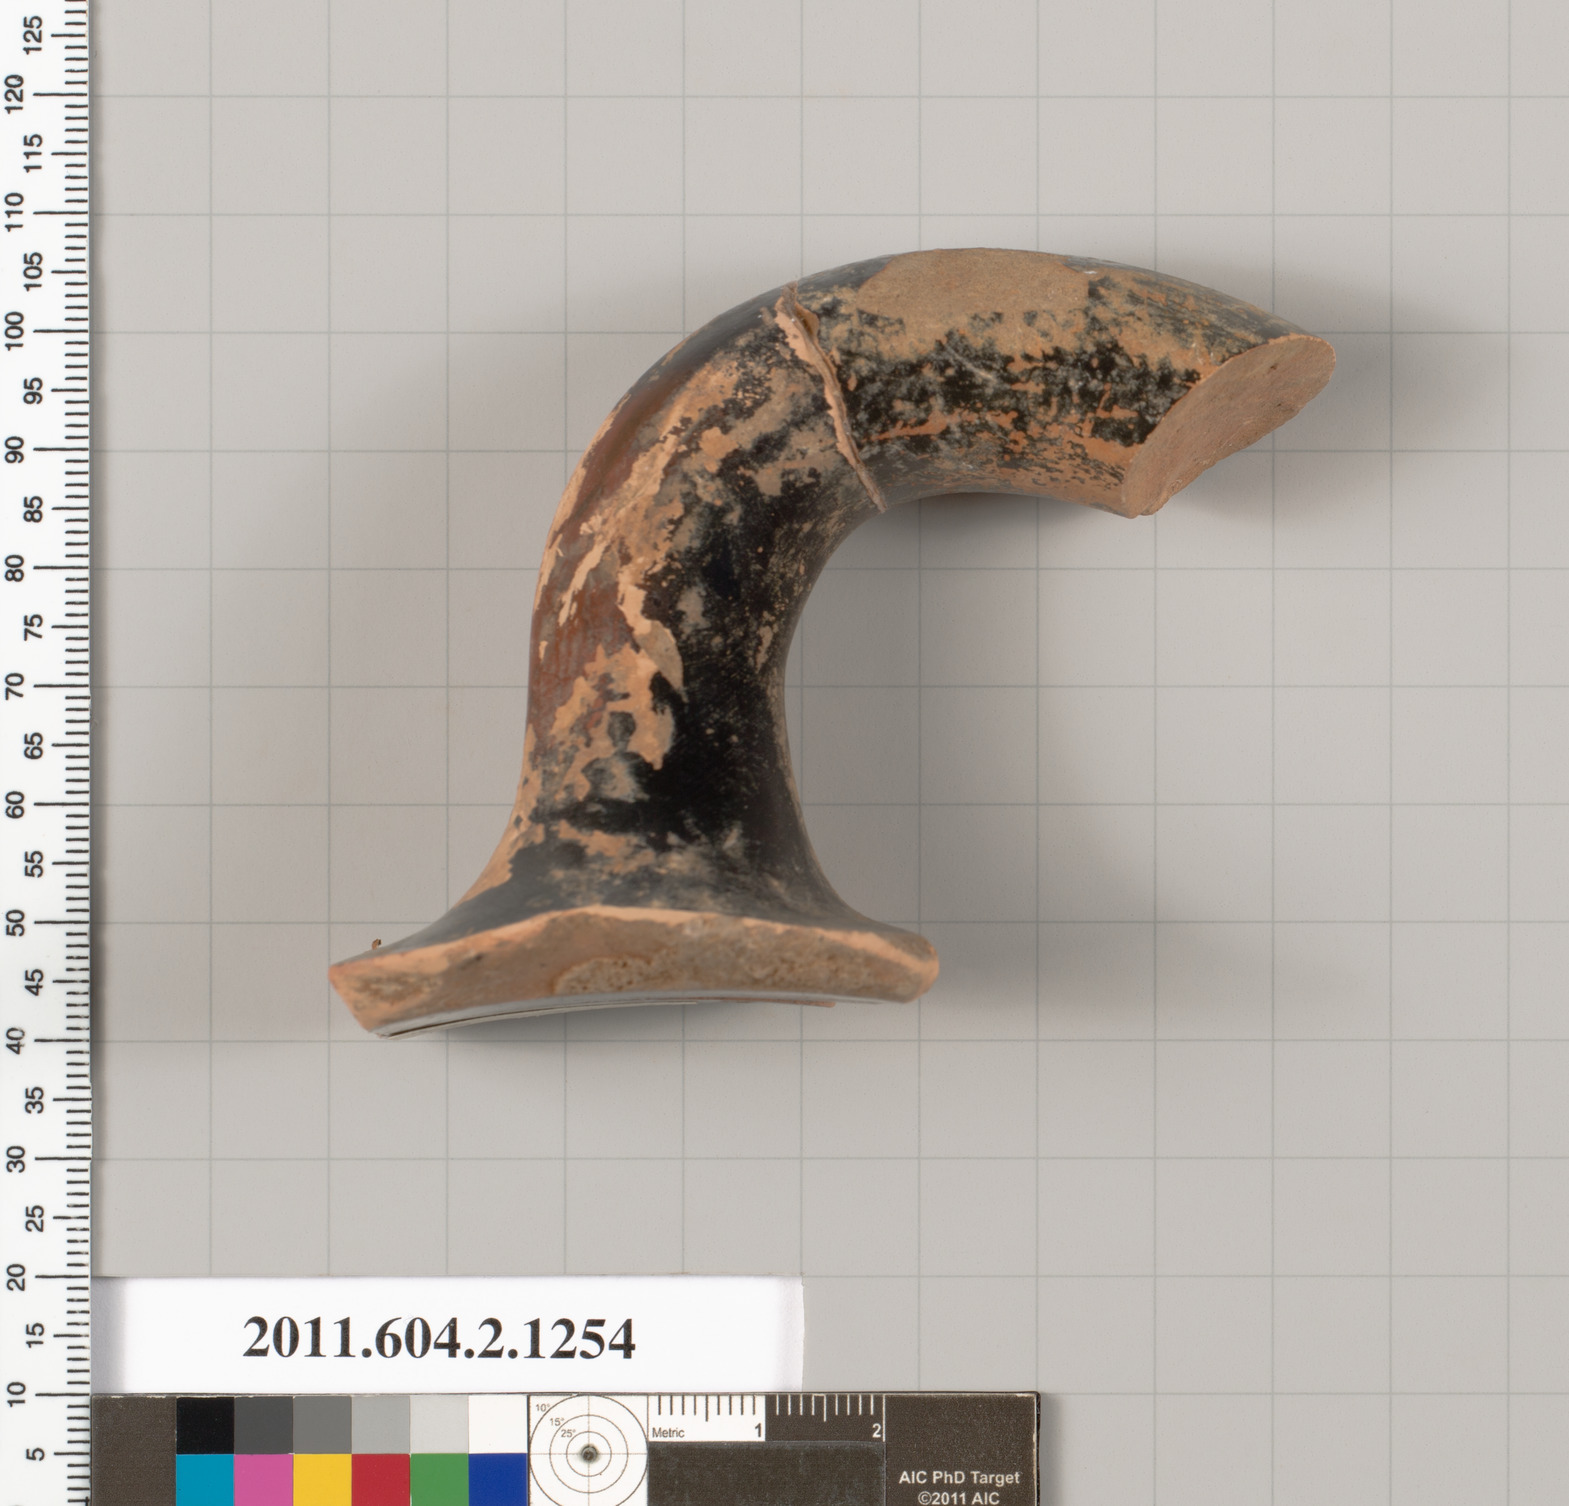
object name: skyphos fragment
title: Terracotta fragment of a skyphos (deep drinking cup)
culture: greek, attic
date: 500-451 BCE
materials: terracotta